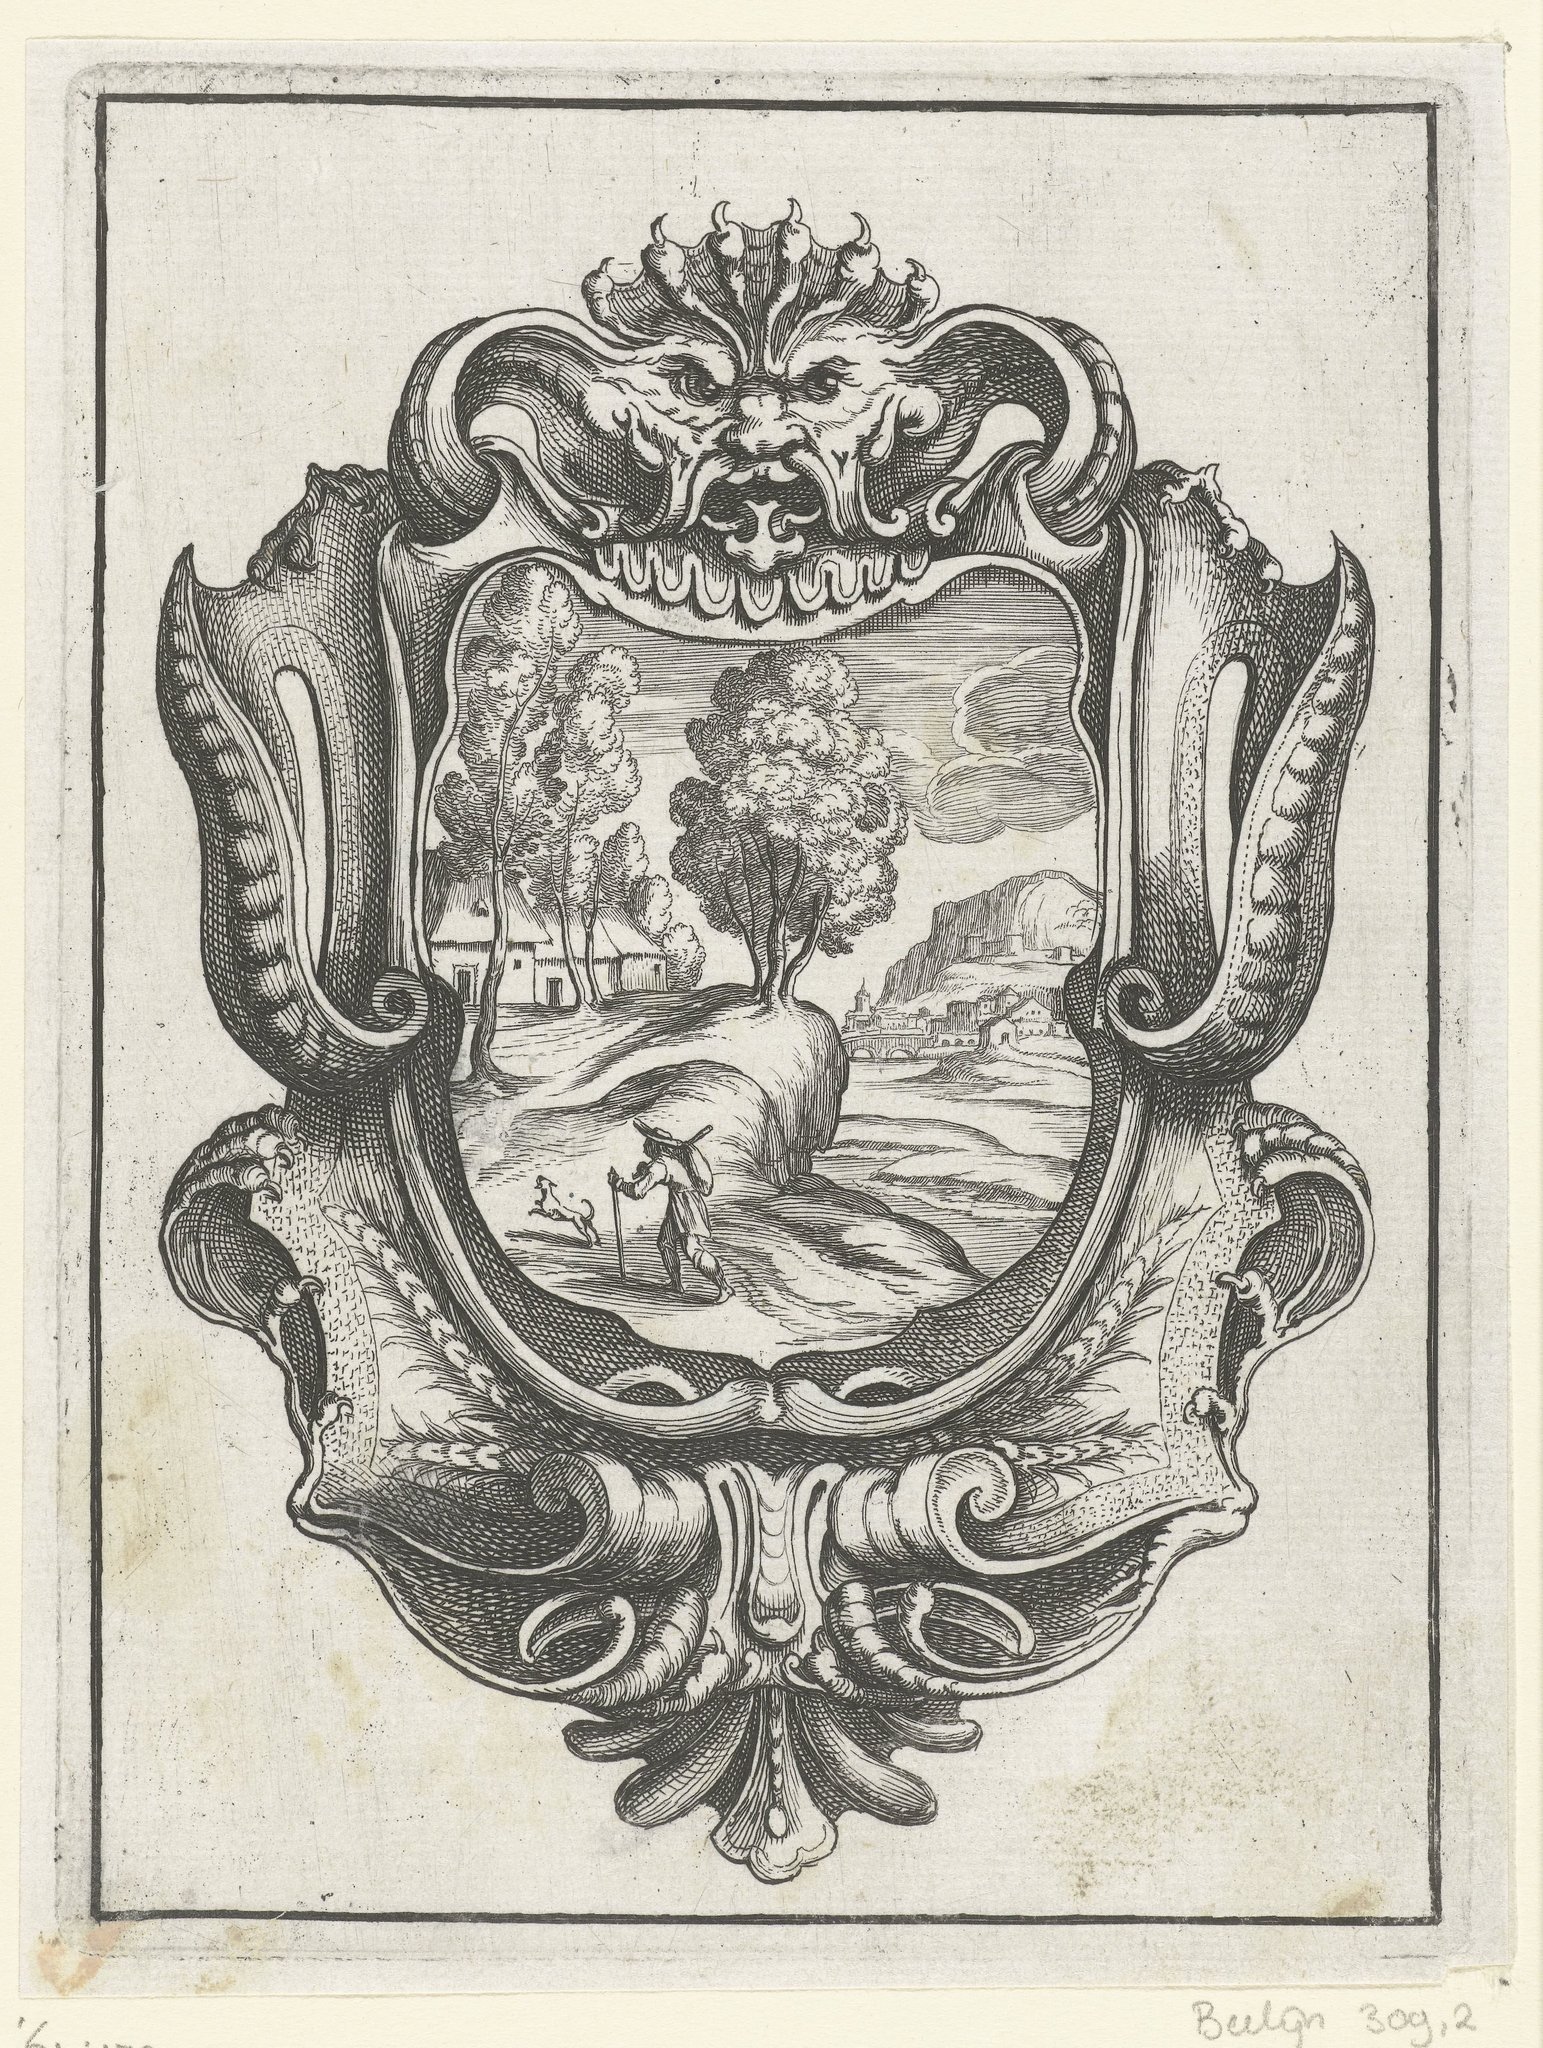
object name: ornament print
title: Cartouche met masker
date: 1632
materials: paper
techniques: engraving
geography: paris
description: Het voorhoofd van het masker bestaat uit een waaiervormige klauw van een roofvogel. In de cartouche staat een heuvelachtig landschap afgebeeld met een rivier en op de achtergrond een stad. Blad 5 uit serie van 13 bladen met cartouches in Franse kwabstijl.